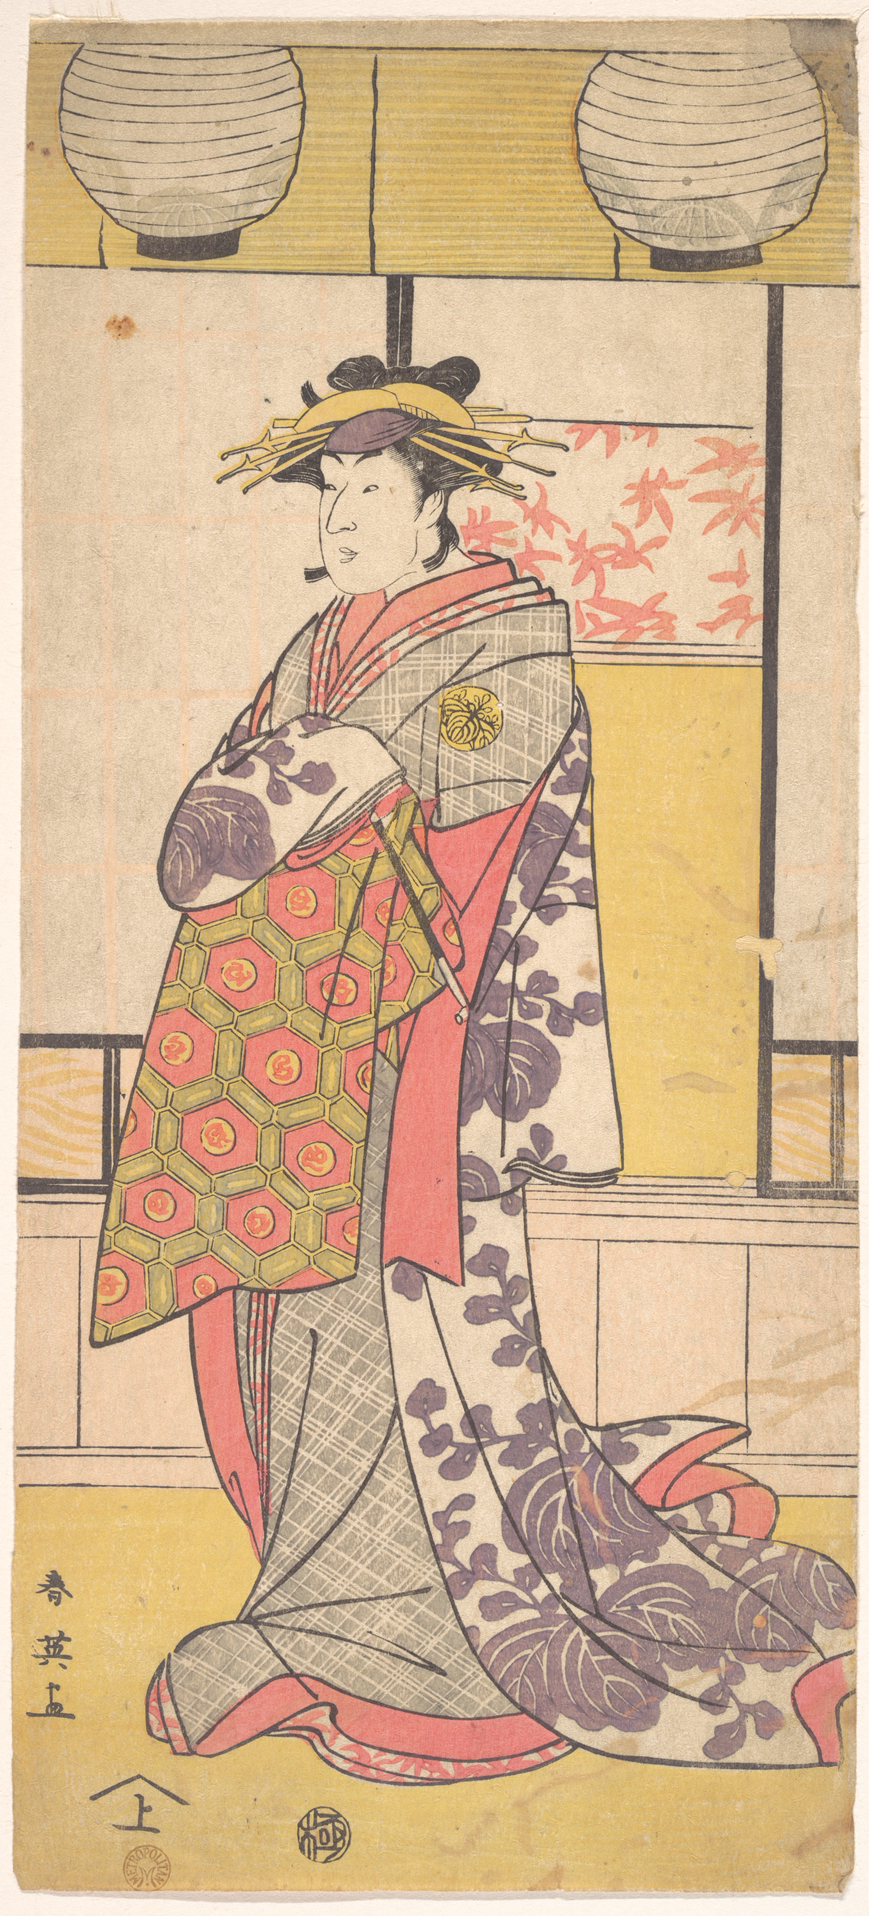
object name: print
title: Nakayama Tatezo as a Courtesan Standing, Facing Toward the Left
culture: japanese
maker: katsukawa shun'ei 勝川春英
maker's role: artist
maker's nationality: japanese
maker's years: 1762-1819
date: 1792-1793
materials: ink, paper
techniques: woodblock print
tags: women,actors